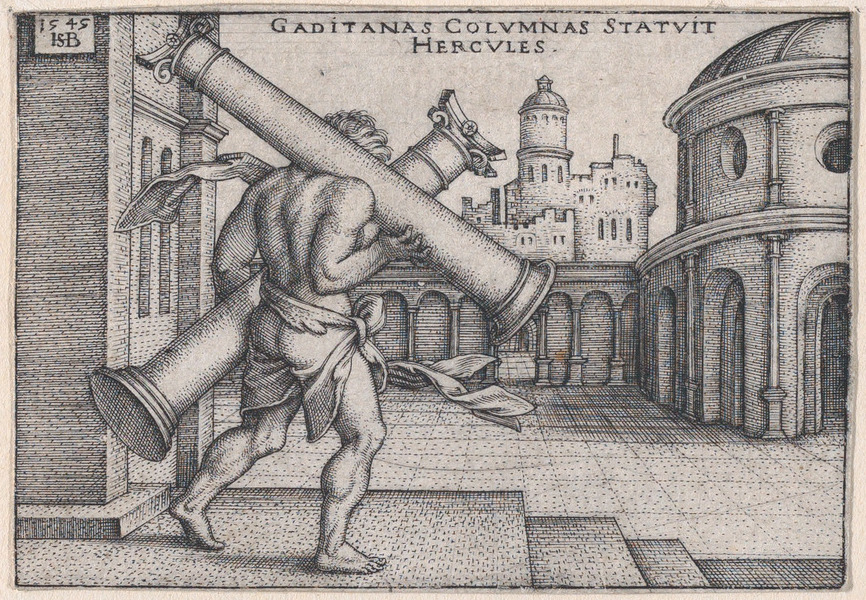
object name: print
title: Death of Hercules from The Labors of Hercules (copy)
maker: sebald beham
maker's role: artist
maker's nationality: german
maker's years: 1500-1550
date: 1520-1600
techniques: engraving